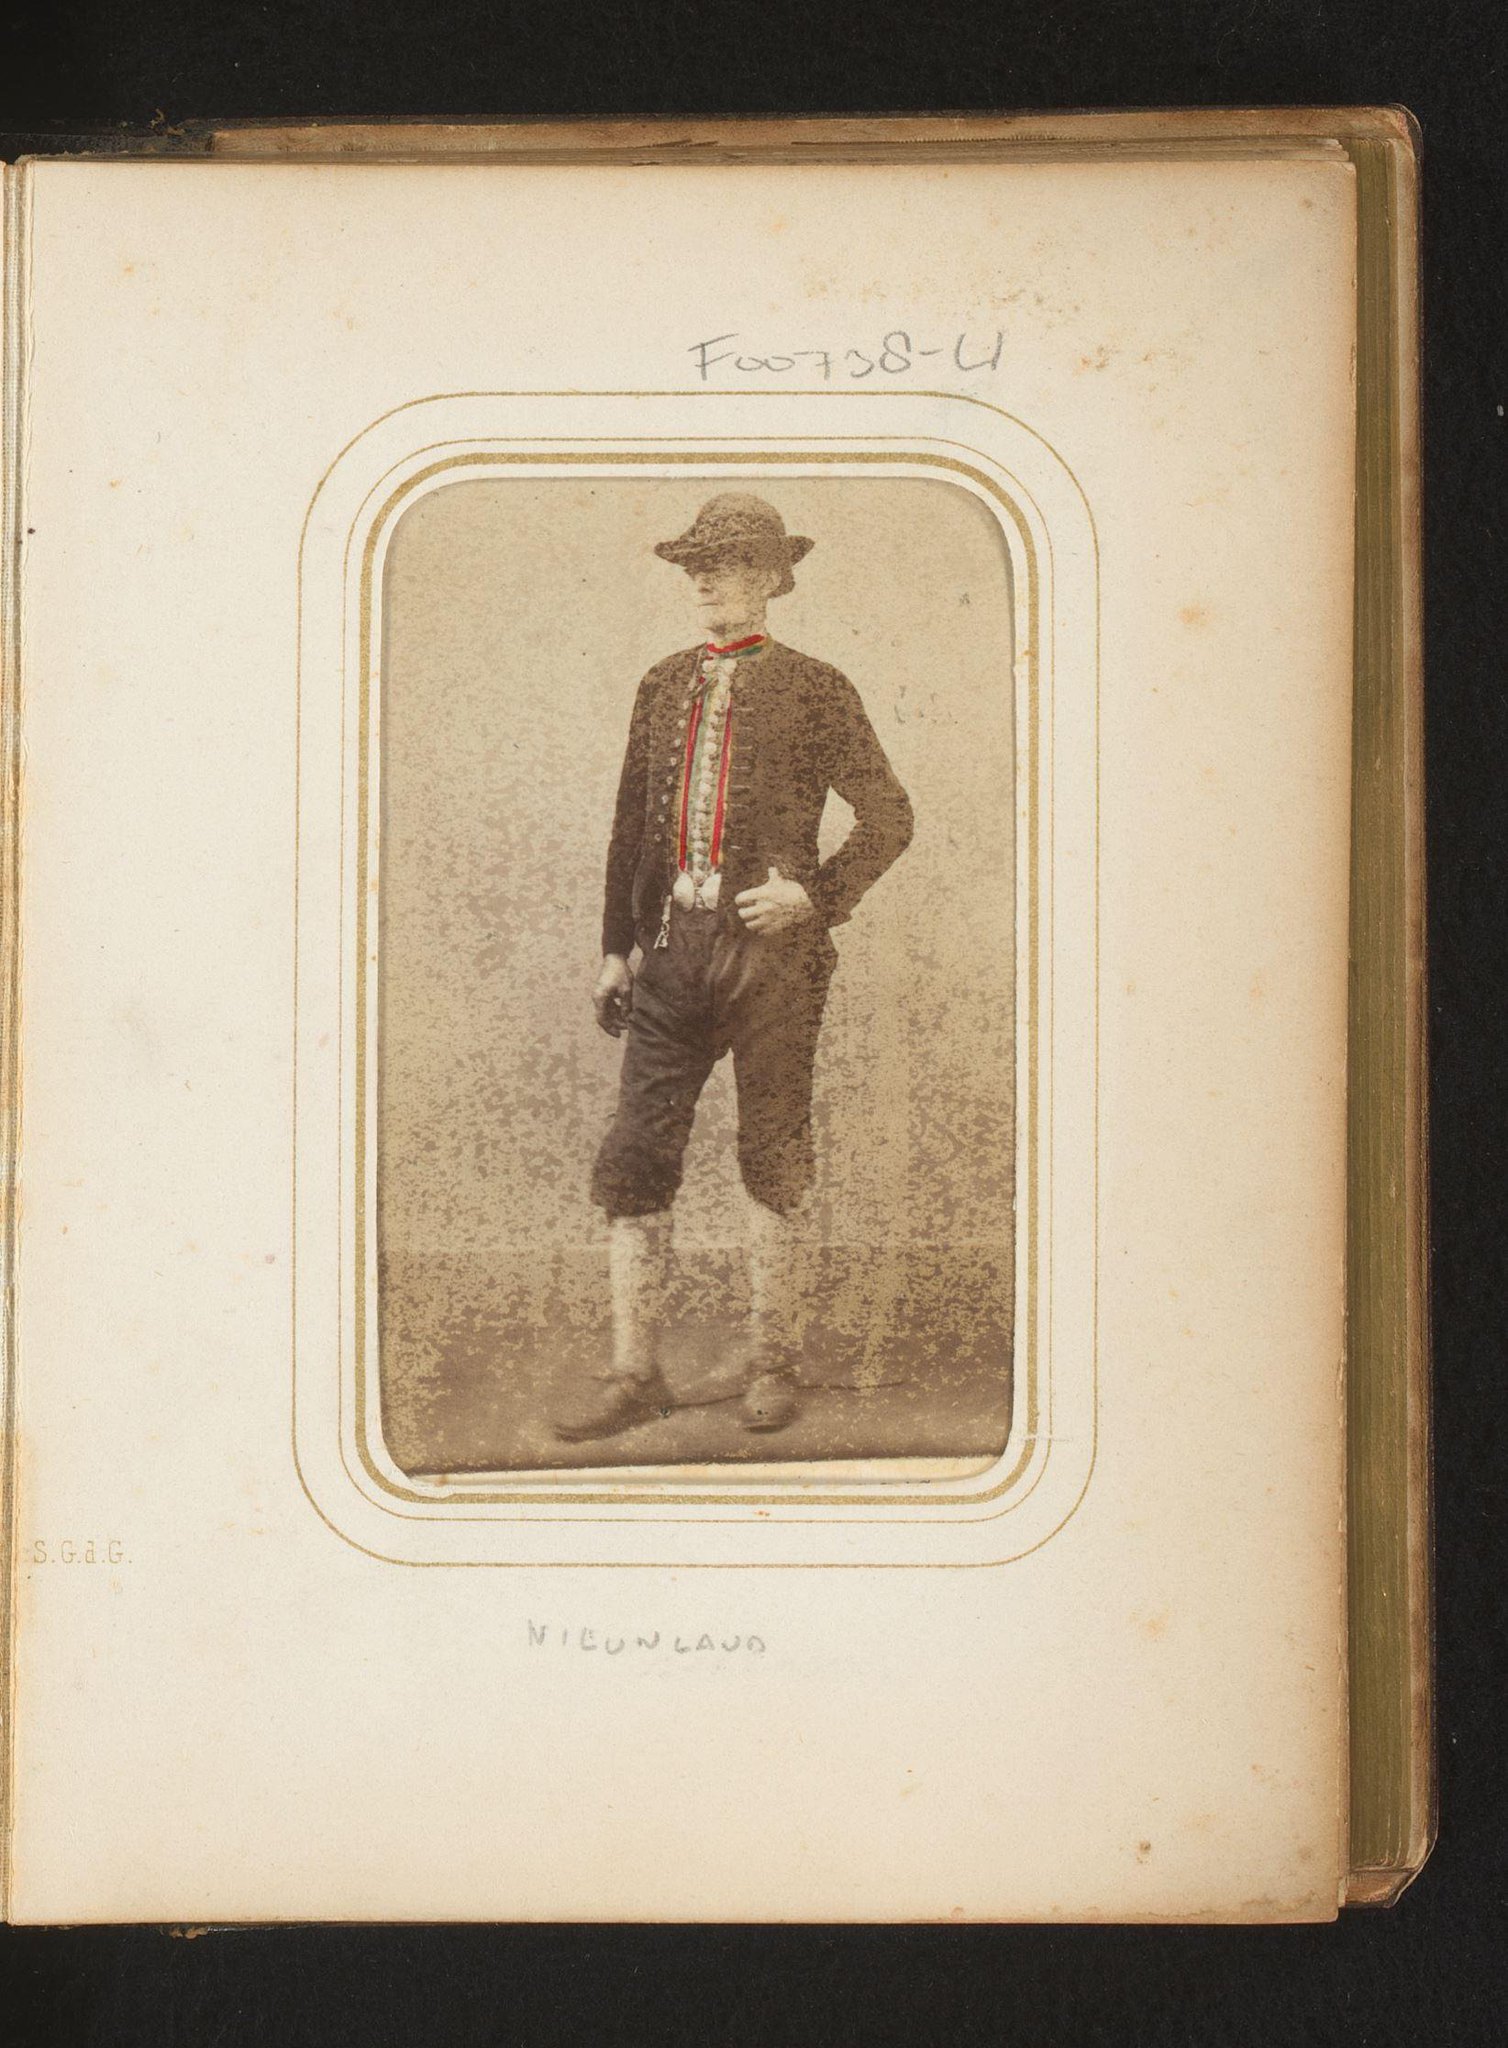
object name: carte de visite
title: Costumes des Pays-Bas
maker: andries jager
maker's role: publisher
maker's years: 1825-1905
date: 1860-1890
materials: cardboard, photographic support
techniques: albumen print, hand coloring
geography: amsterdam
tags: standing figure, folk costume, regional costume (+ men's clothes), historical persons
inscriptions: inscription: ‘Breveté S.G.D.G.’, annotation: ‘Nieuwland’, inscription: ‘Publiés par A. Jager, Water 110, Amsterdam./ Le droit de reproduction réservé.’